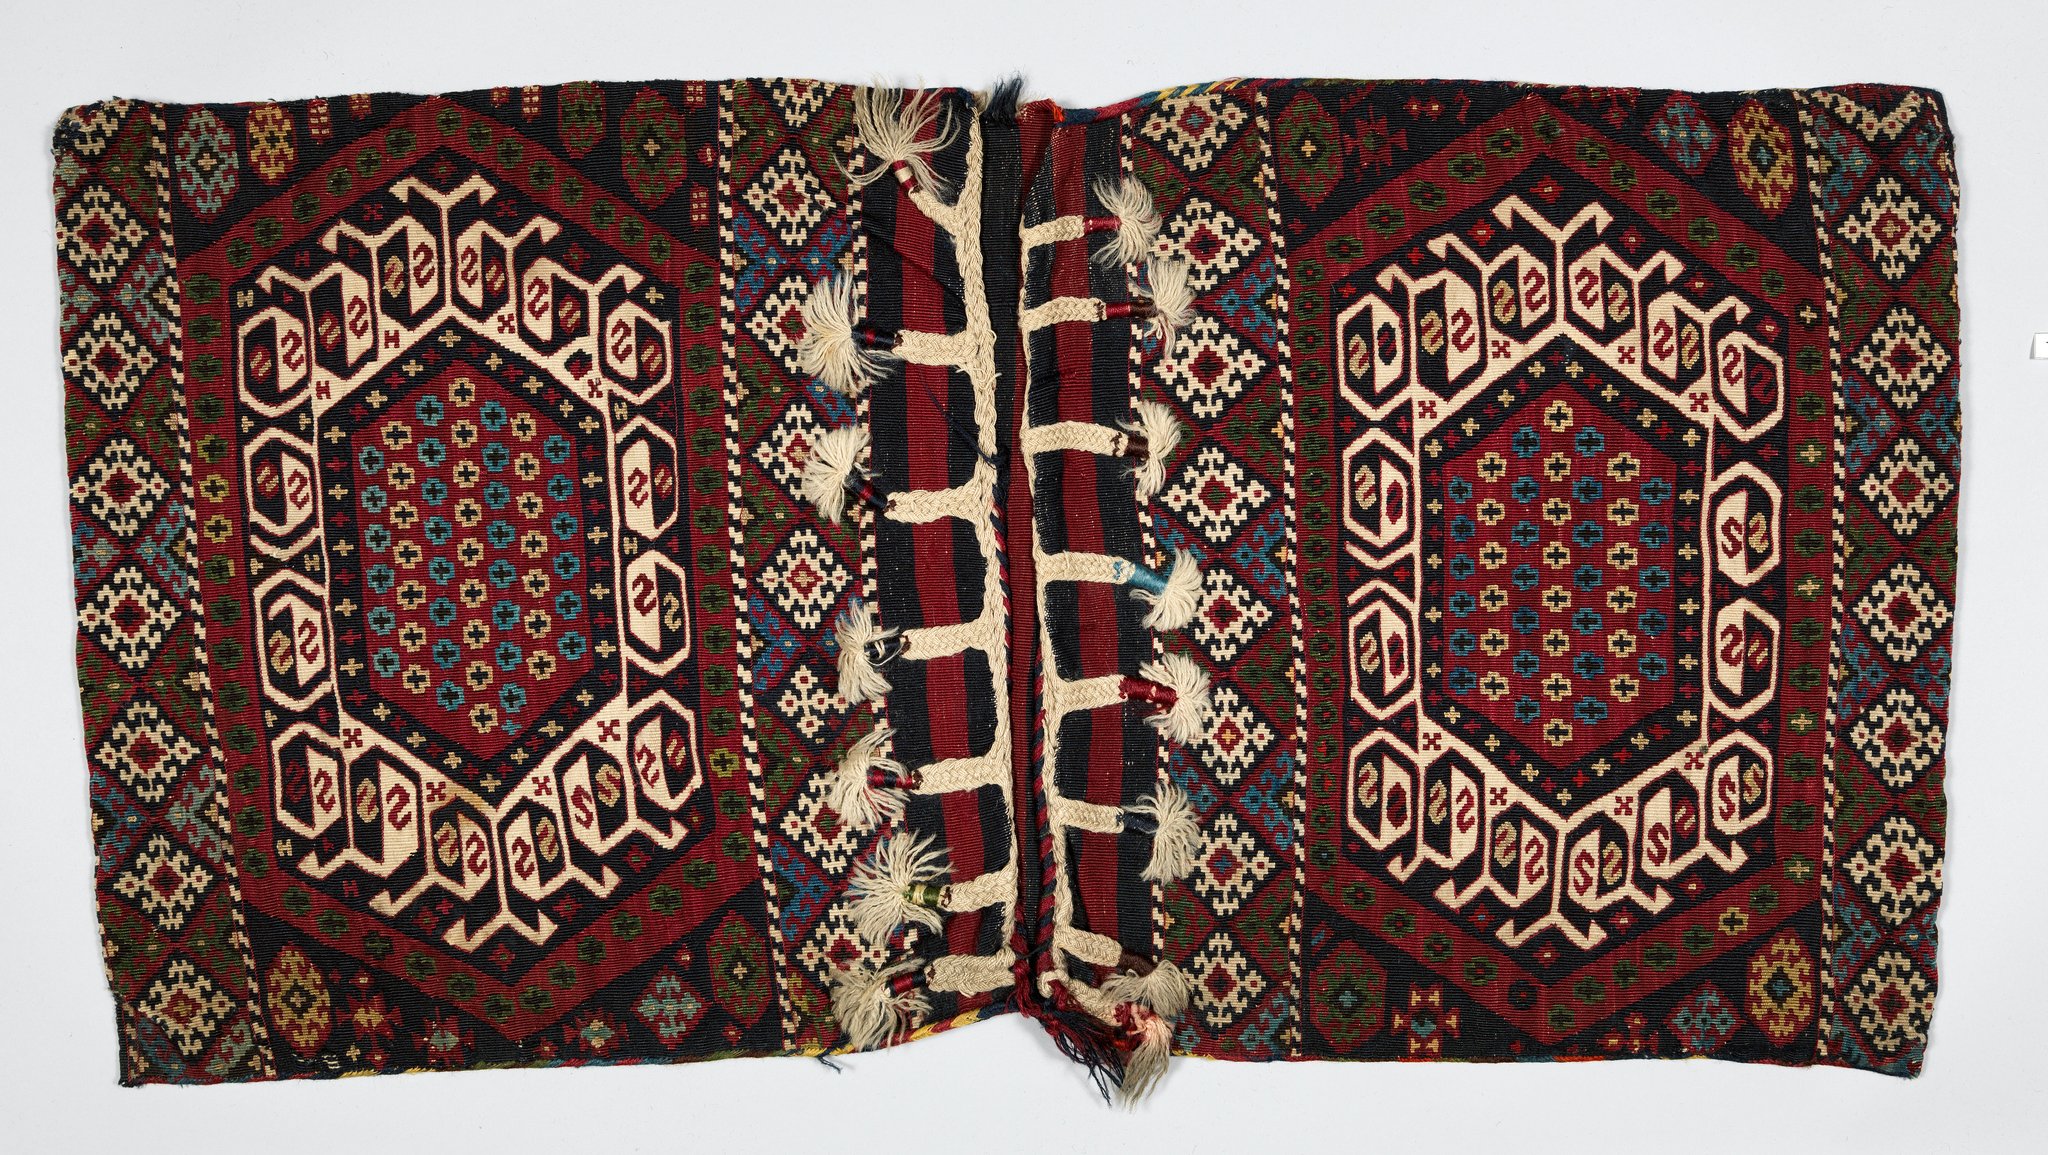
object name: saddle bag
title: Double Saddle Bag (Heybe)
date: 1880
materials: brass, copper, cotton, metal, wool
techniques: weave, slit, tapestry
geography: turkey